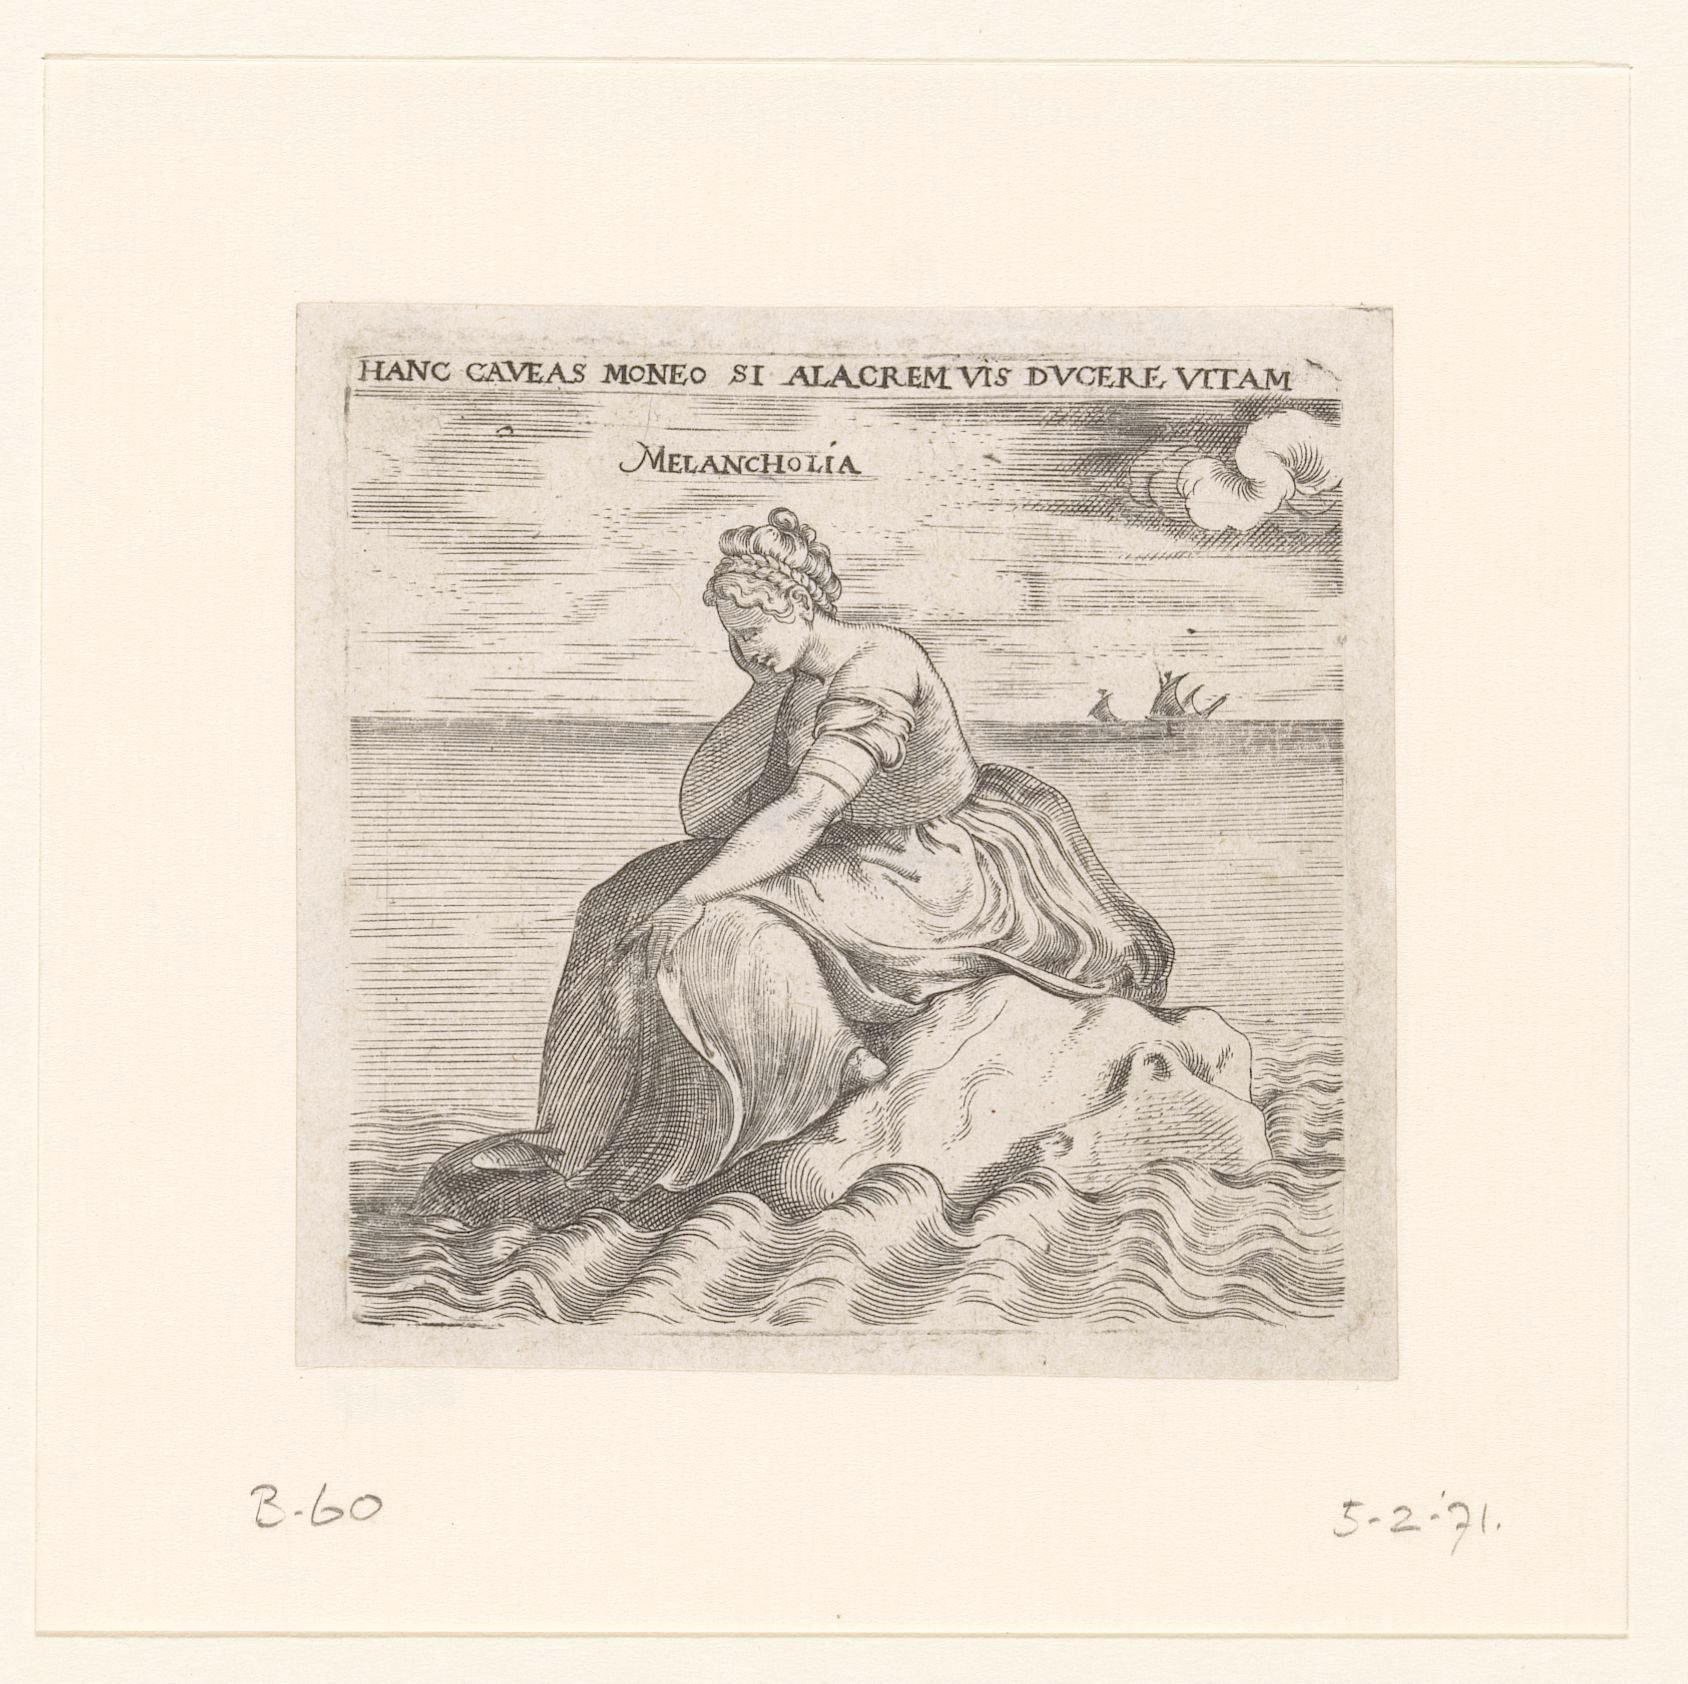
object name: print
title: Melancholia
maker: francesco salviati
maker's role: draughtsman, painter, print maker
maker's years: 1510-1563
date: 1533-1567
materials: paper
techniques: engraving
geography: italy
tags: 'malenconico (per la terra)', 'malinconia' (ripa)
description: Melancholie (Melancolia) als vrouw zittend op een rots in het water. Bovenaan een regel tekst in het Latijn.